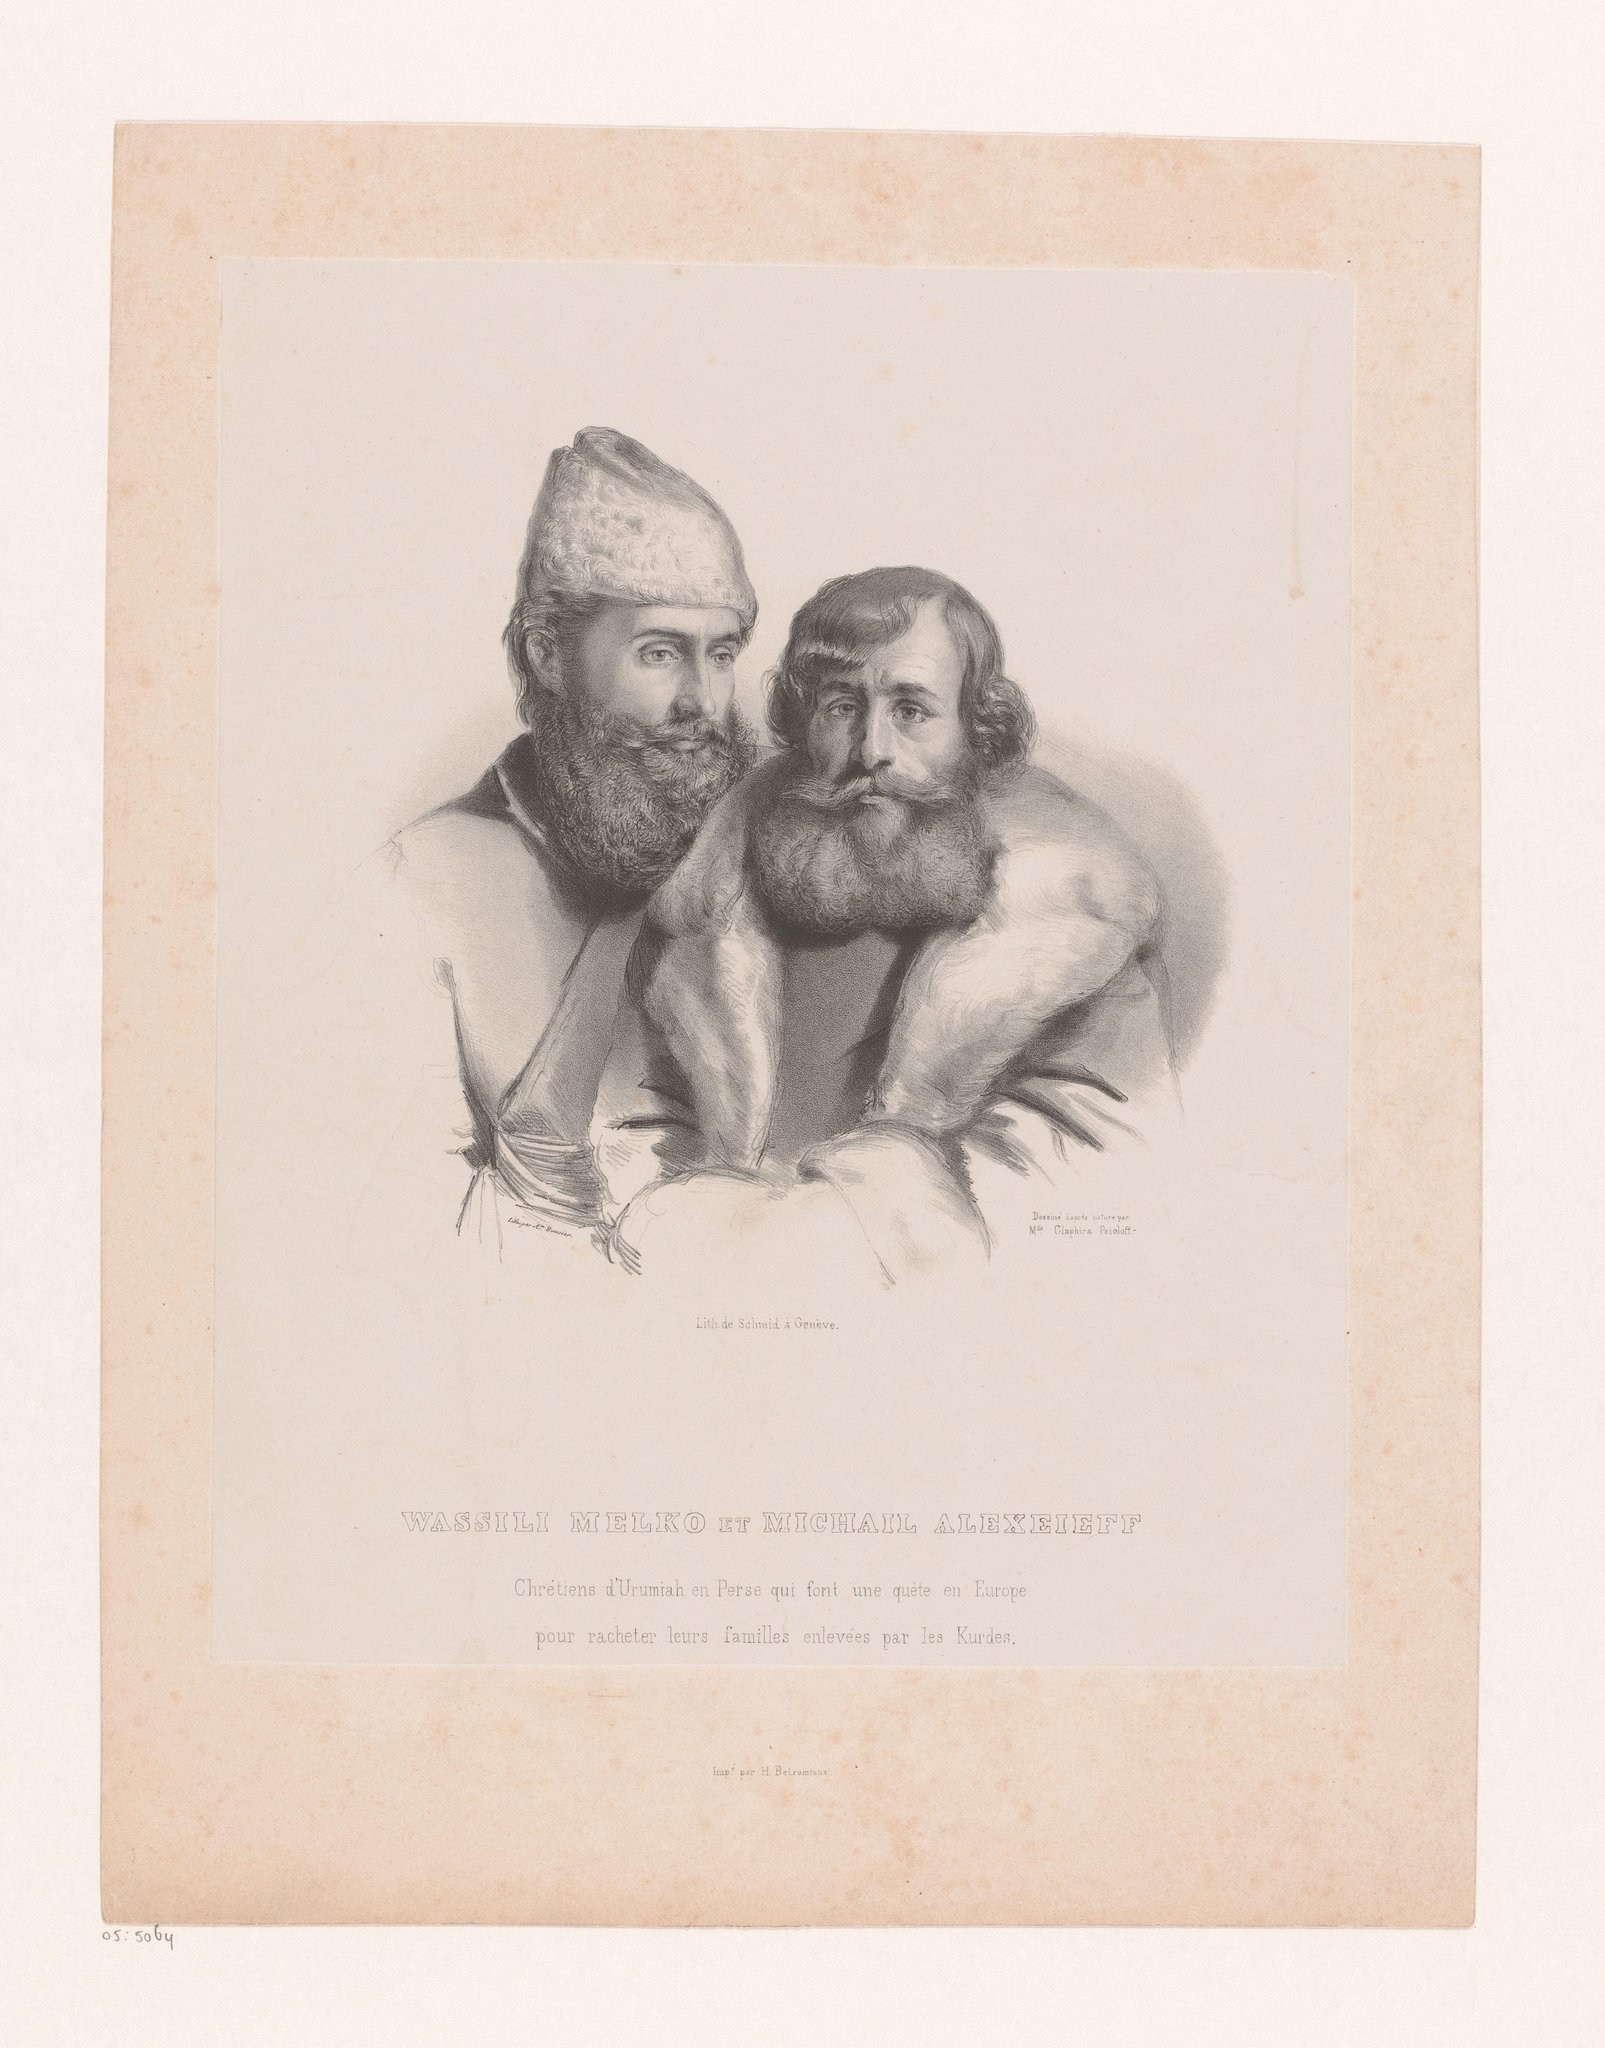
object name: print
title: Dubbelportret van Wassili Melko en Michail Alexeieff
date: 1800-1899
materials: paper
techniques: lithograph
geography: geneva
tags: adult man (+ two persons), historical persons, beard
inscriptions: collector's mark: Lugt 2228